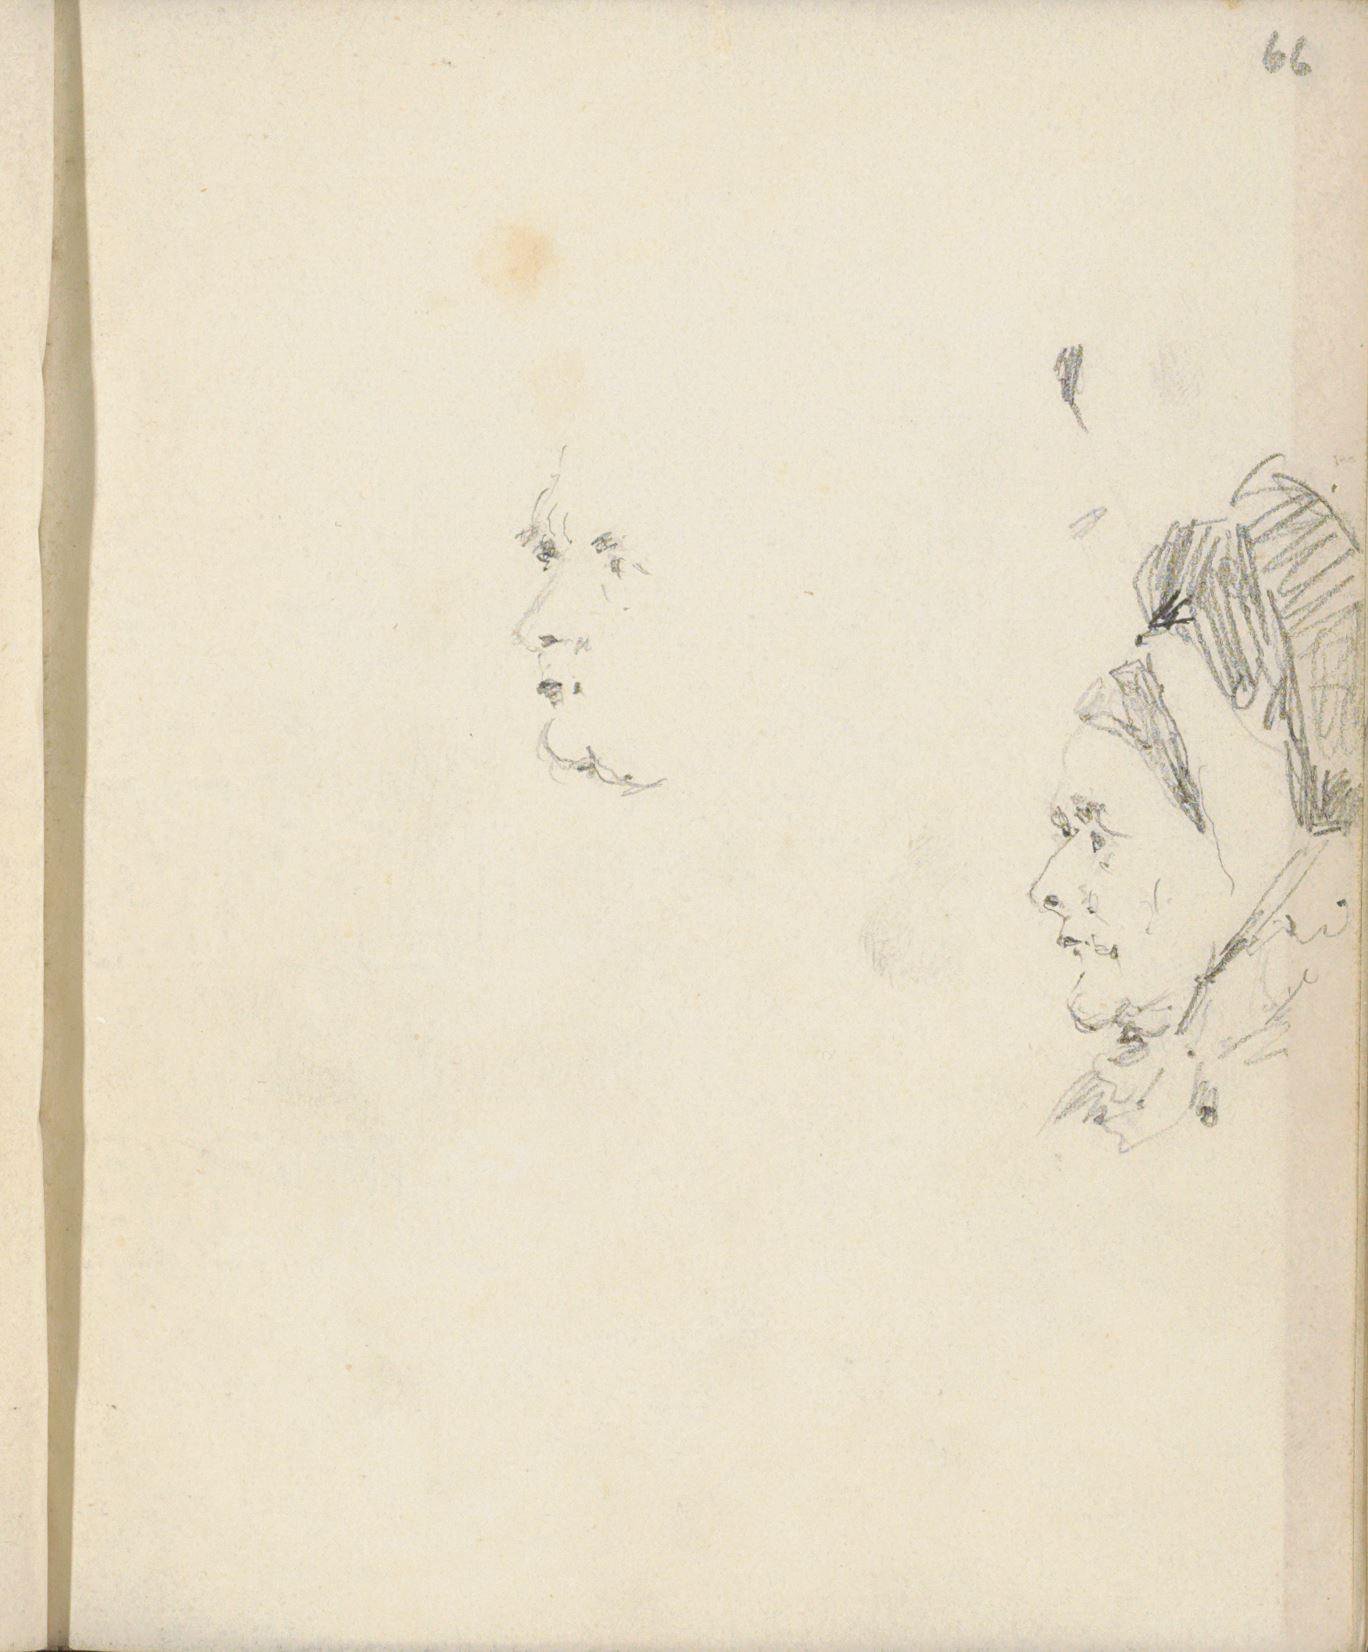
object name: sketchbook leaf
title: Hoofd van een oudere vrouw met een muts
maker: alfred william rich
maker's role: draughtsman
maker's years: 1856-1921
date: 1892-1893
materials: paper, pencil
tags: folk costume, regional costume (+ women's clothes), head (human) (+ old female (human being))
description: Blad 66 recto uit een schetsboek met 86 bladen.